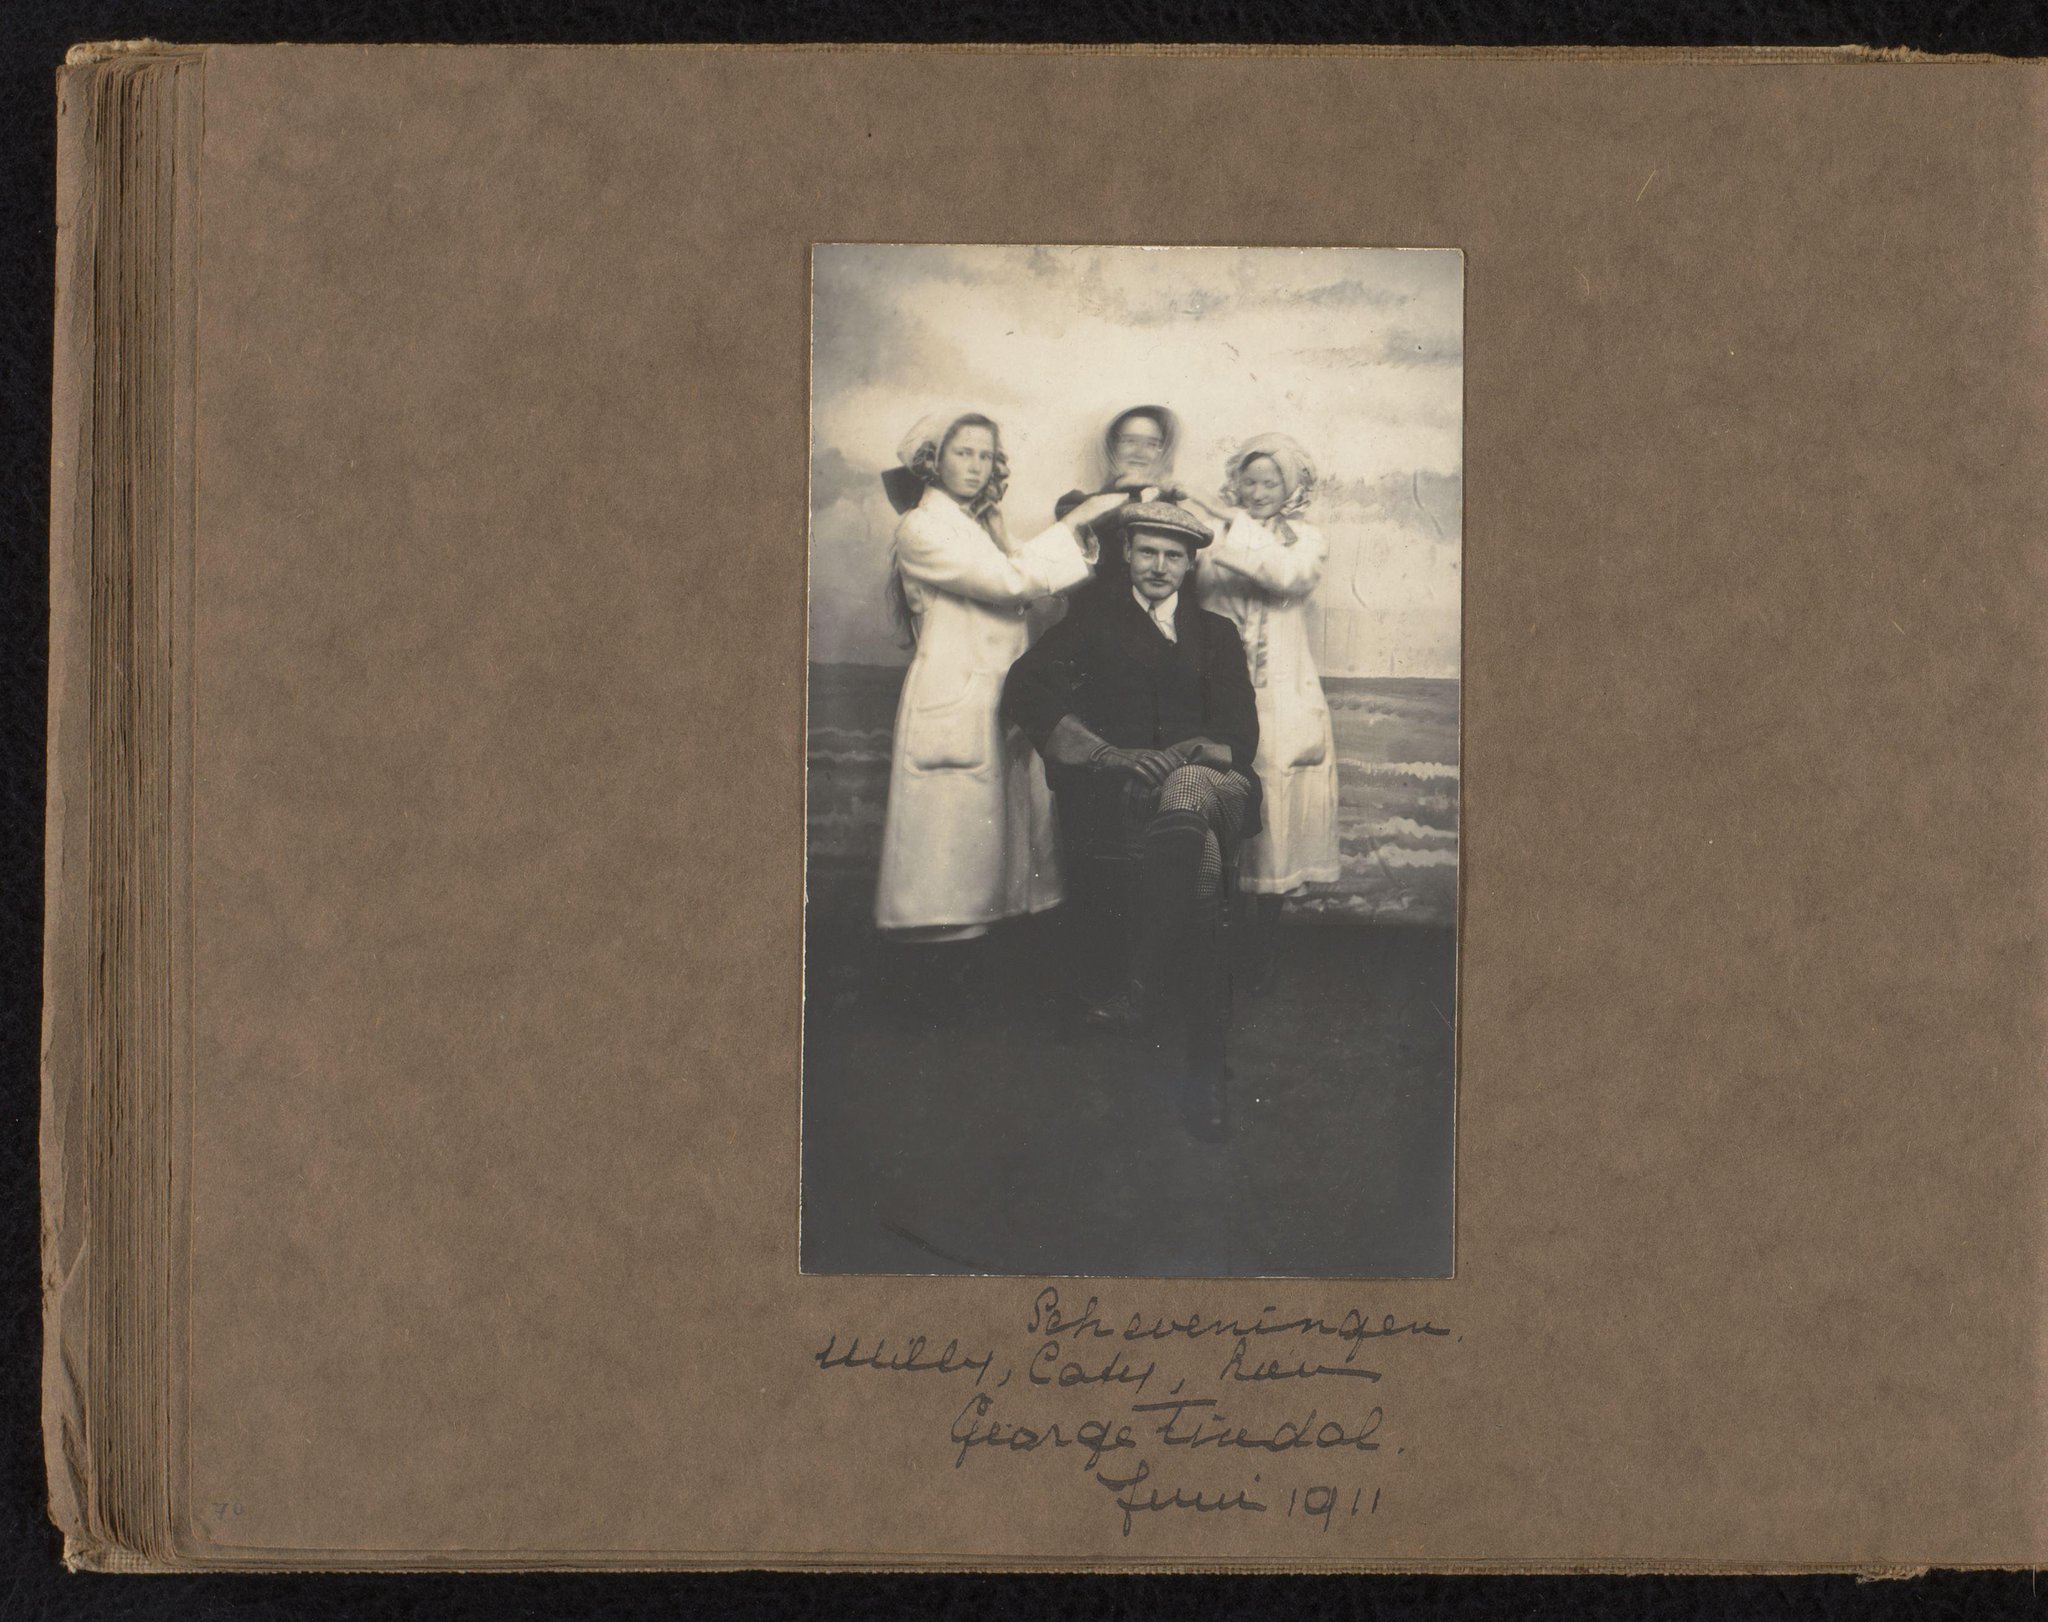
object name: photograph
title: Groepsportret van drie meisjes bij een man, mogelijk een piloot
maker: Anonymous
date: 1906-1911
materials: paper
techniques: gelatin silver print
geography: scheveningen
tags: pilot, historical persons